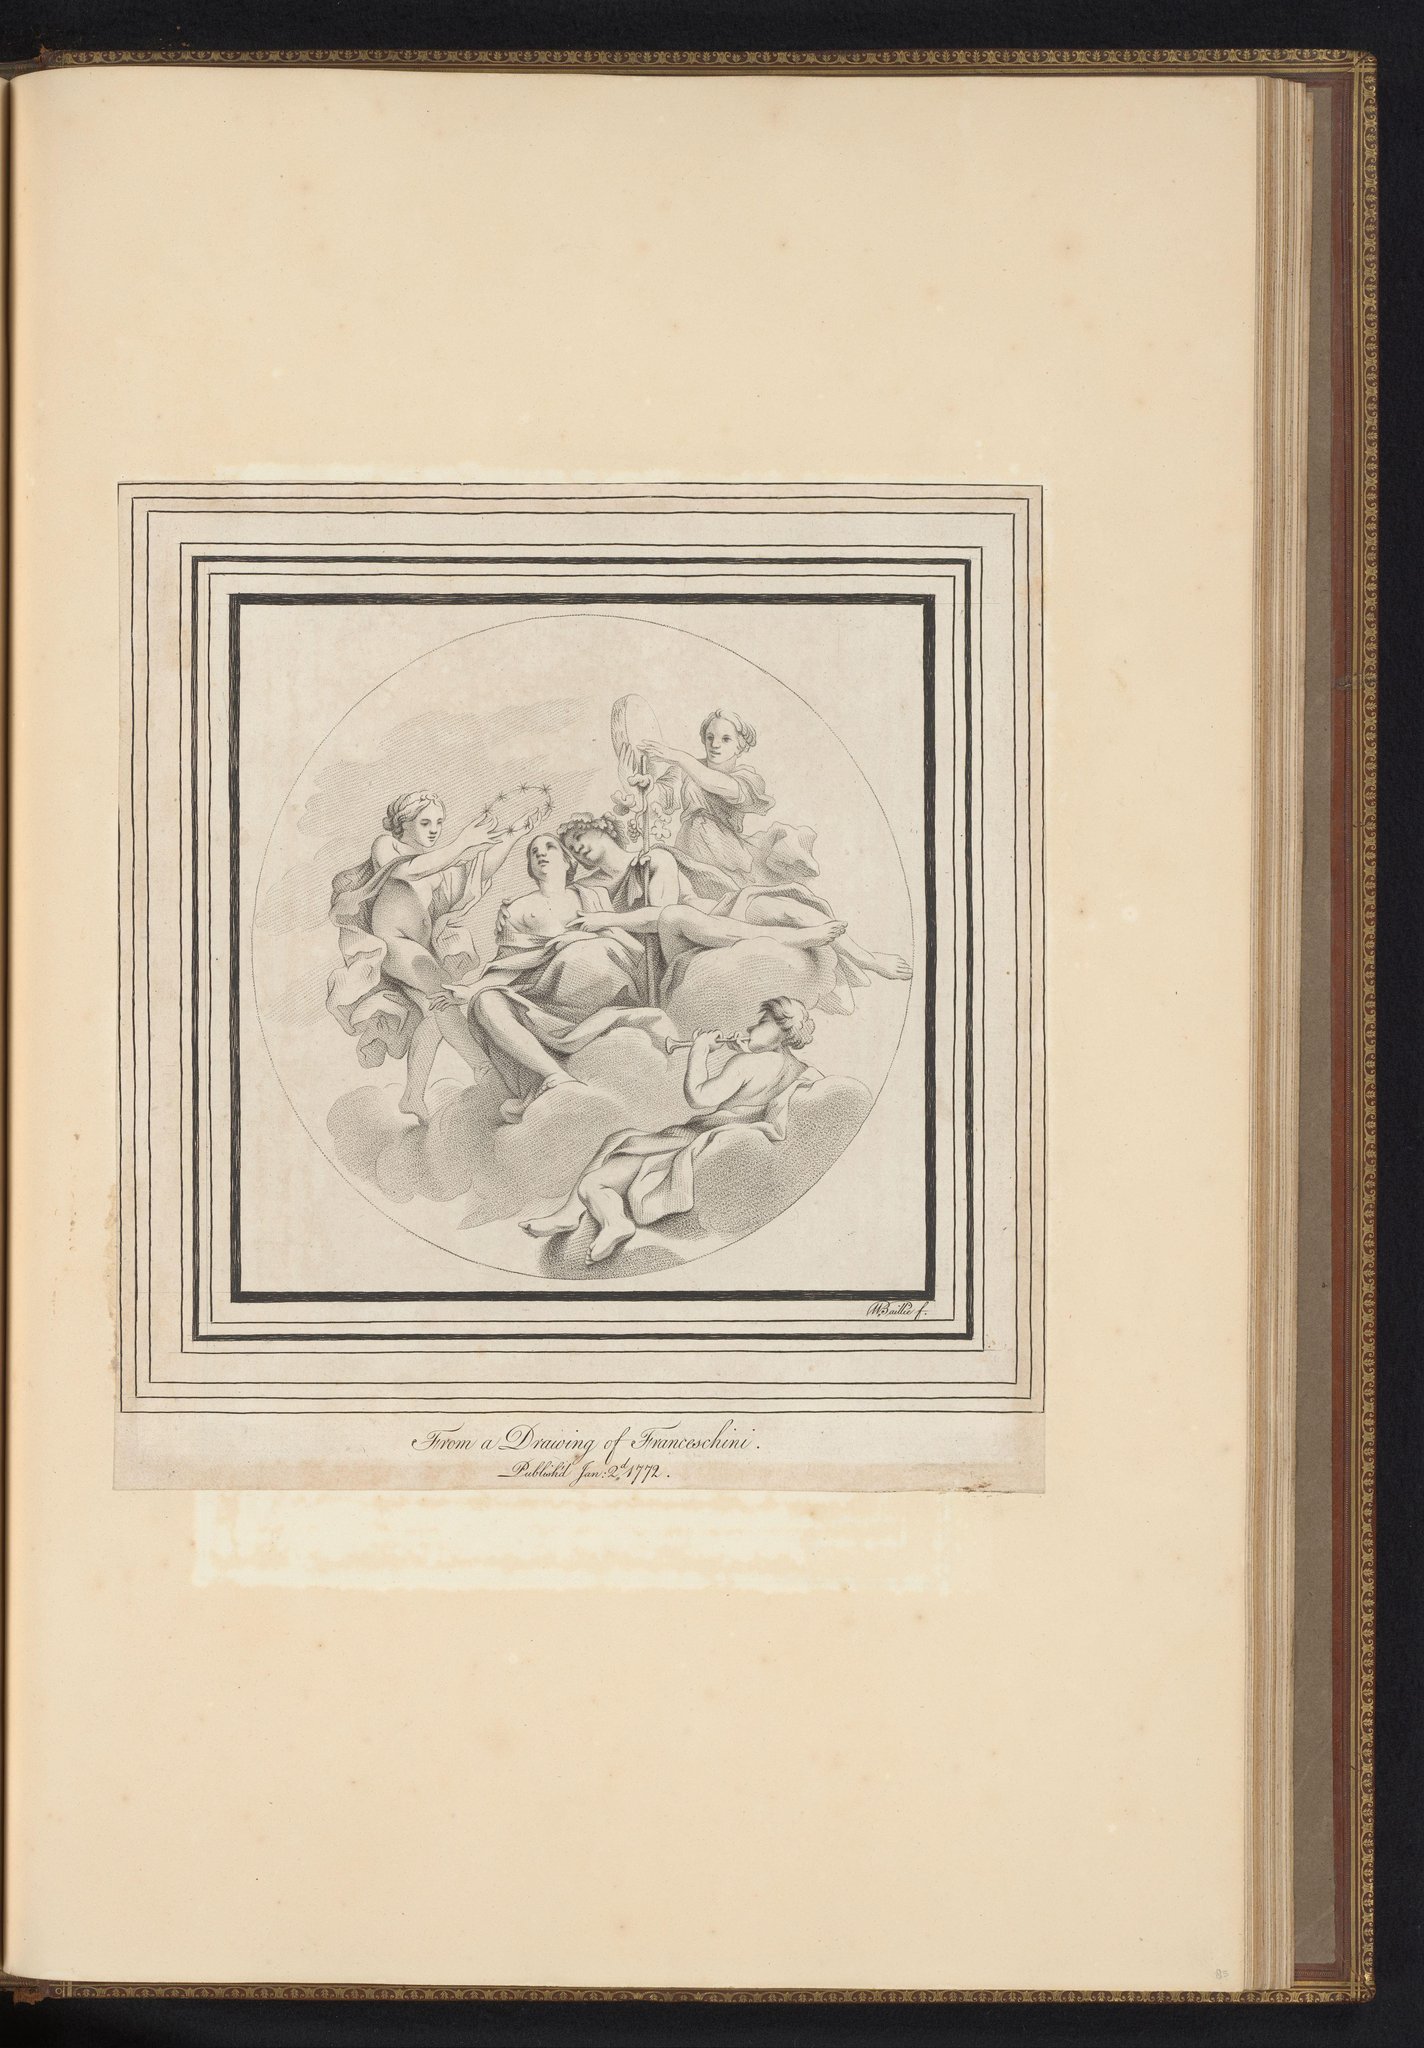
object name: print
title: Bacchus en Ariadne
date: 1772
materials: paper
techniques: printmaking, etching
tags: (story of) ariadne and bacchus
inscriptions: date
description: Bacchus en Ariadne zittend in de wolken. Om hem heen drie figuren. Eén speelt fluit, een tweede tamboerijn. De derde houdt een krans boven het hoofd van Ariadne. De prent maakt deel uit van een album.